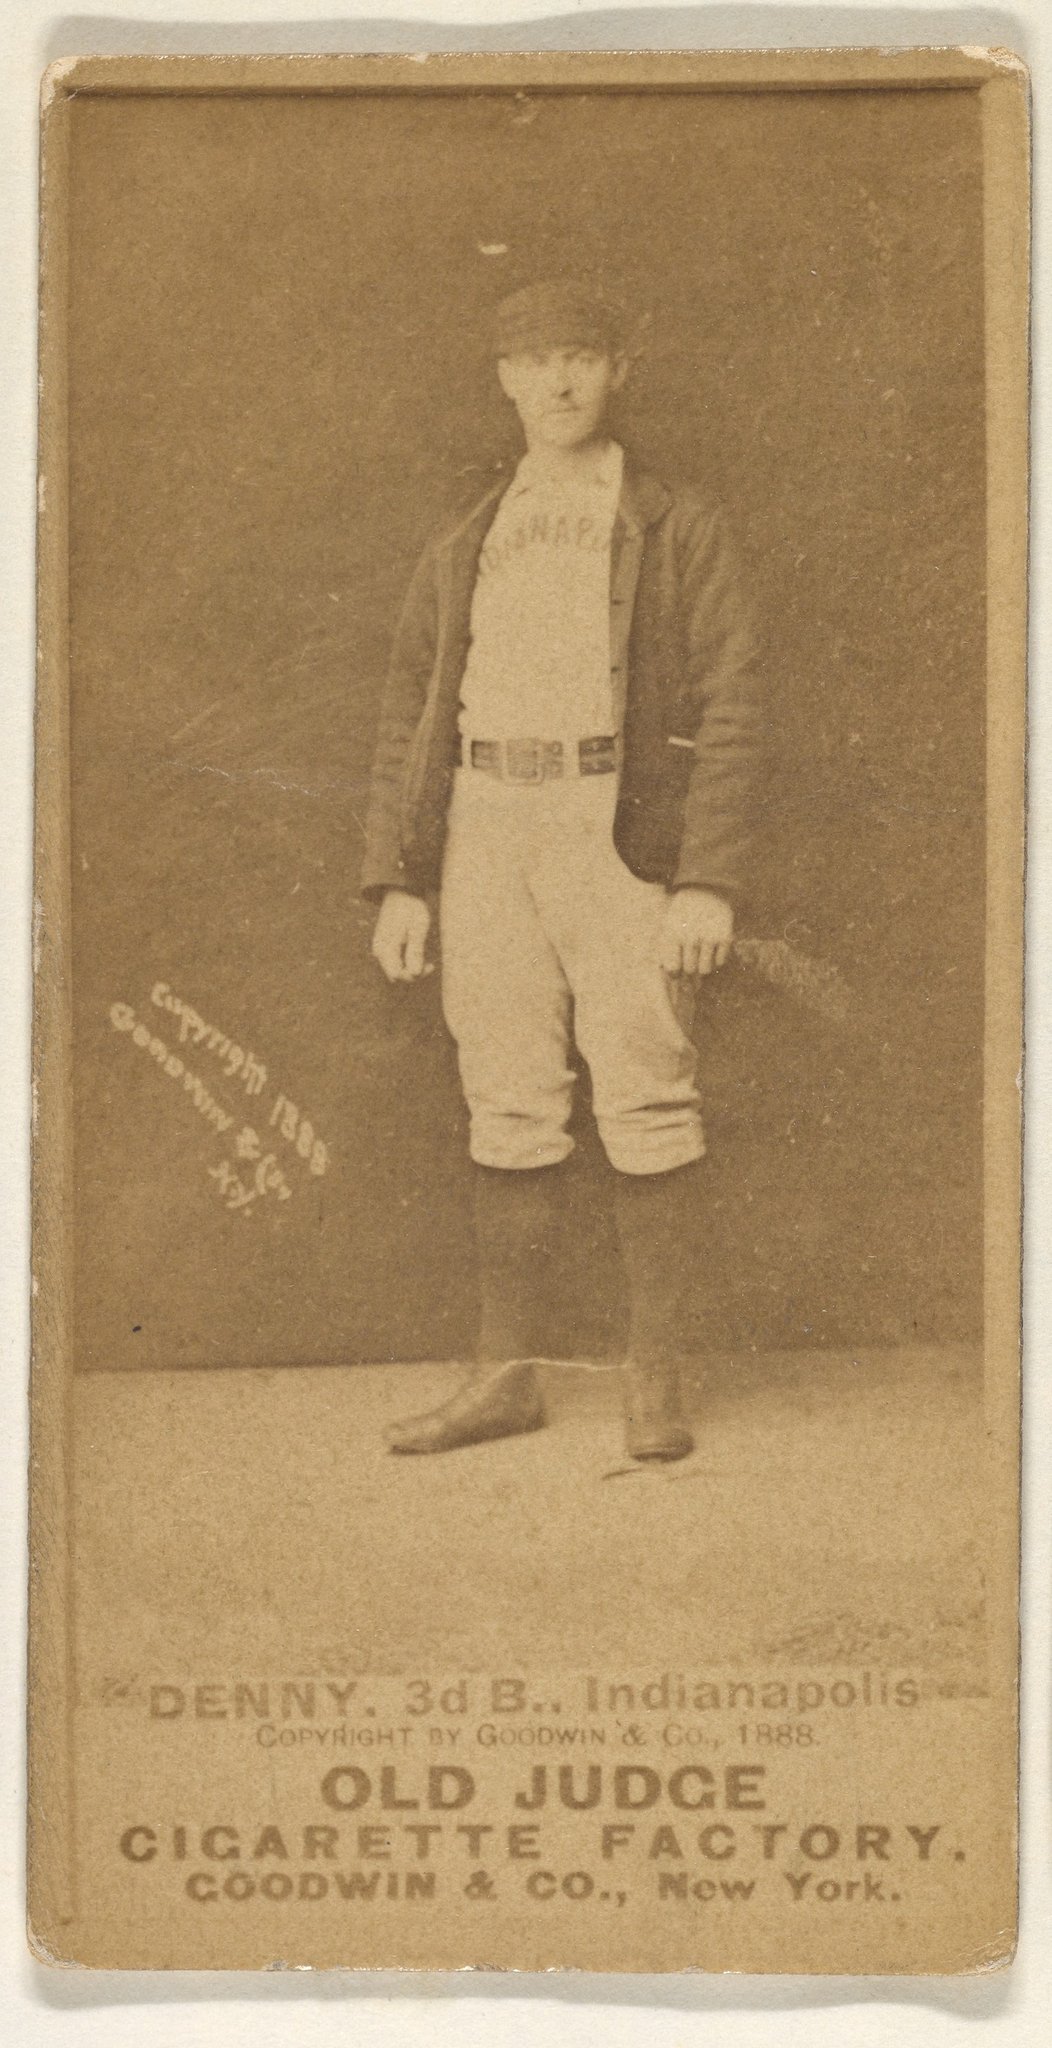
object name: baseball card, photograph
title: Jerry Denny, 3rd Base, Indianapolis, from the Old Judge series (N172) for Old Judge Cigarettes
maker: goodwin & company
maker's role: publisher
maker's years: 1850-1950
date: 1888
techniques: albumen silver print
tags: men,portraits,baseball,athletes